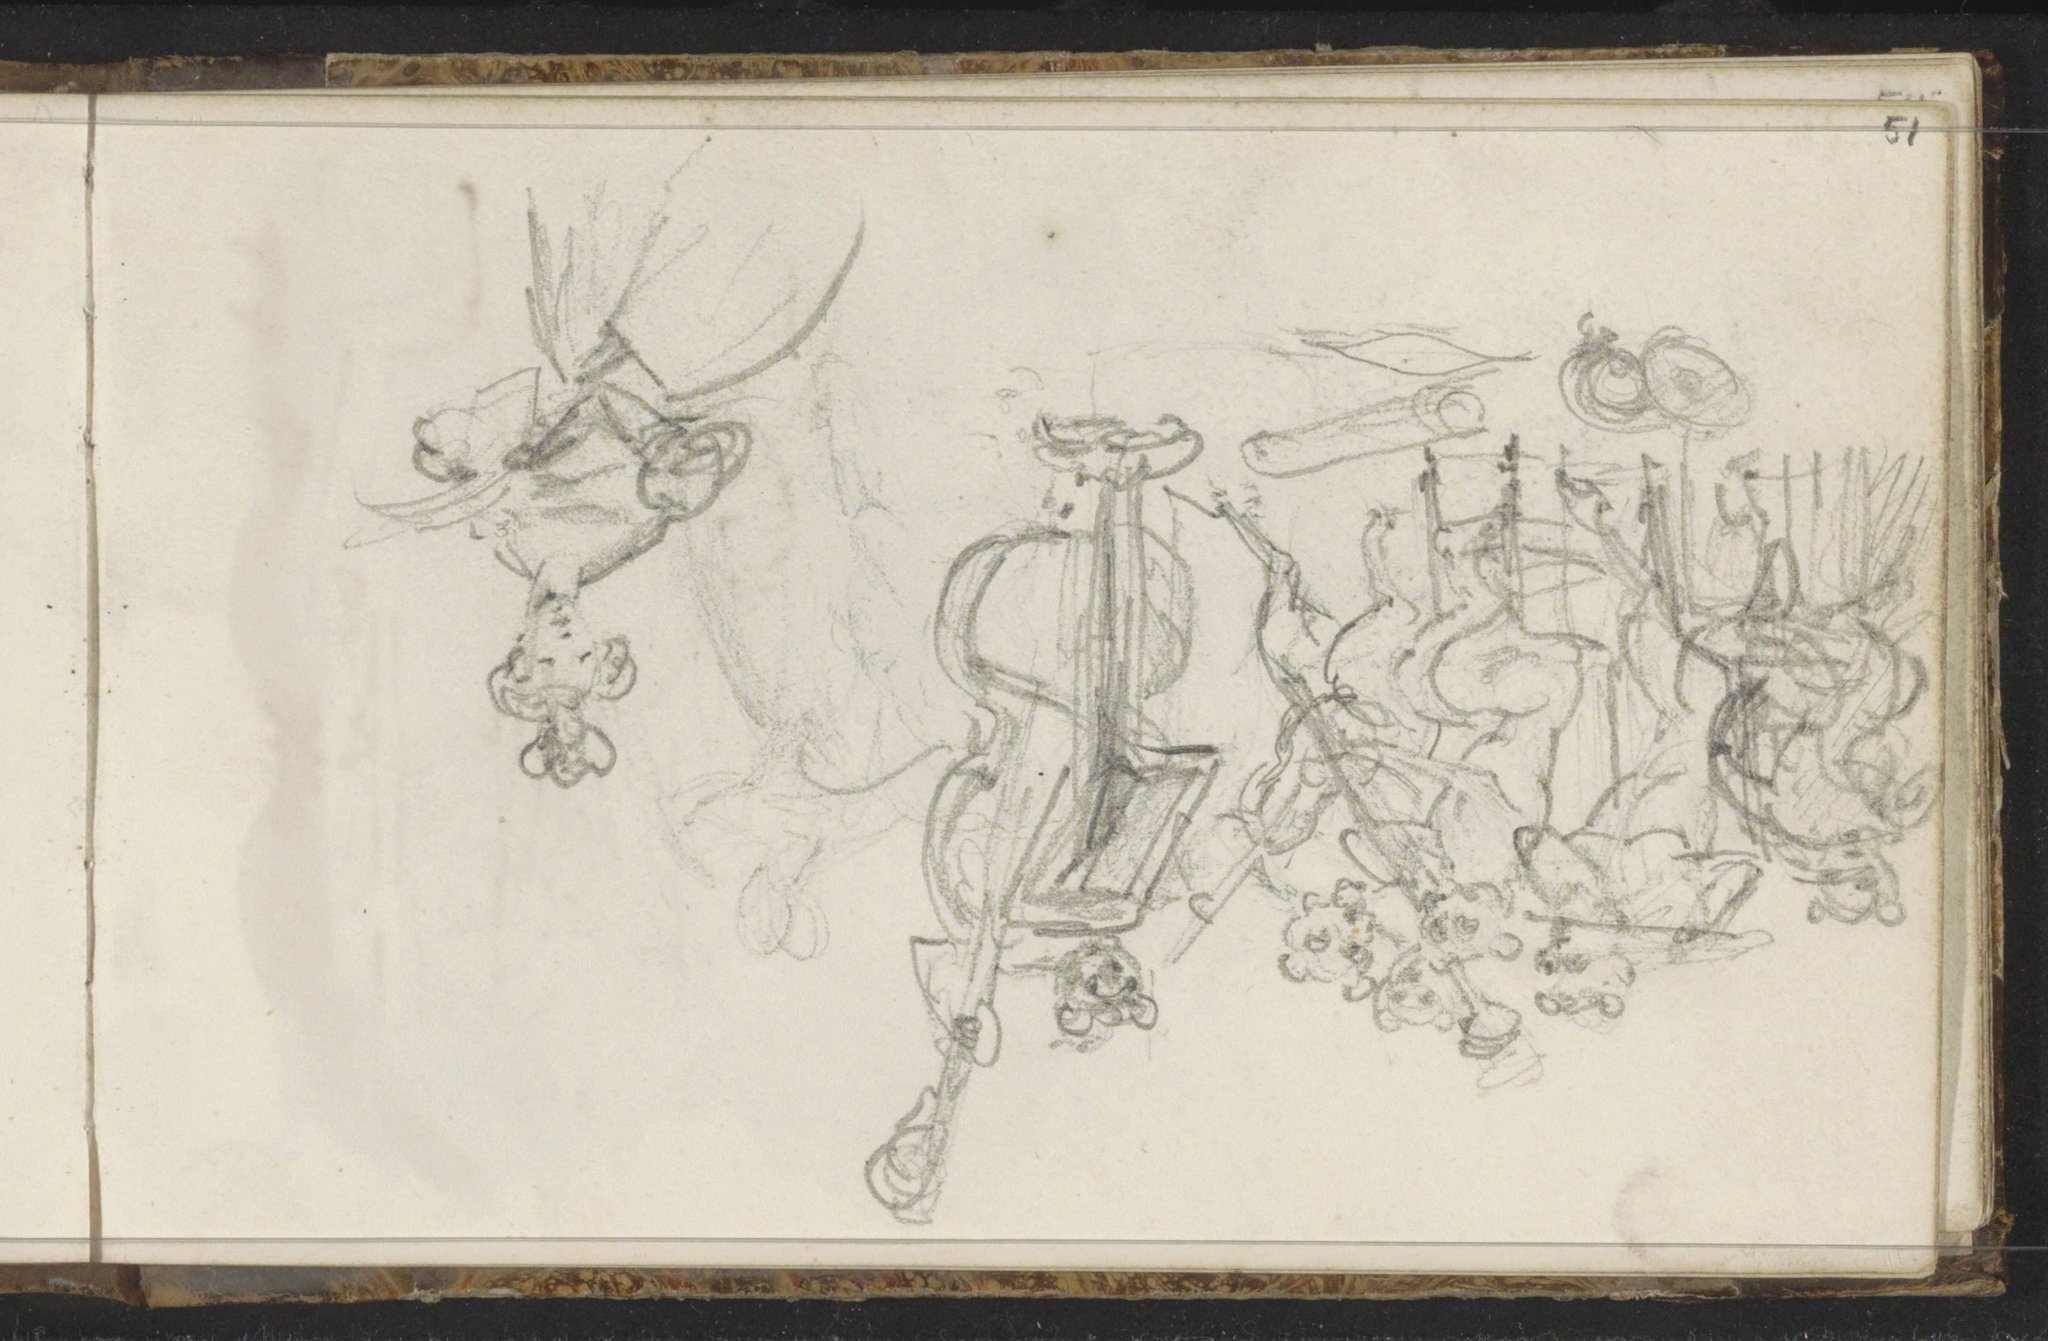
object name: sketchbook leaf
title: Lezende vrouw en een uit dieren bestaand orkest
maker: willem hendrik schmidt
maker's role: draughtsman, painter, print maker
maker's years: 1809-1849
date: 1819-1849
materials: paper, pencil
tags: small group of musicians, chamber orchestra, jazz band, reading, animals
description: Blad 51 recto uit een schetsboek met 60 bladen.